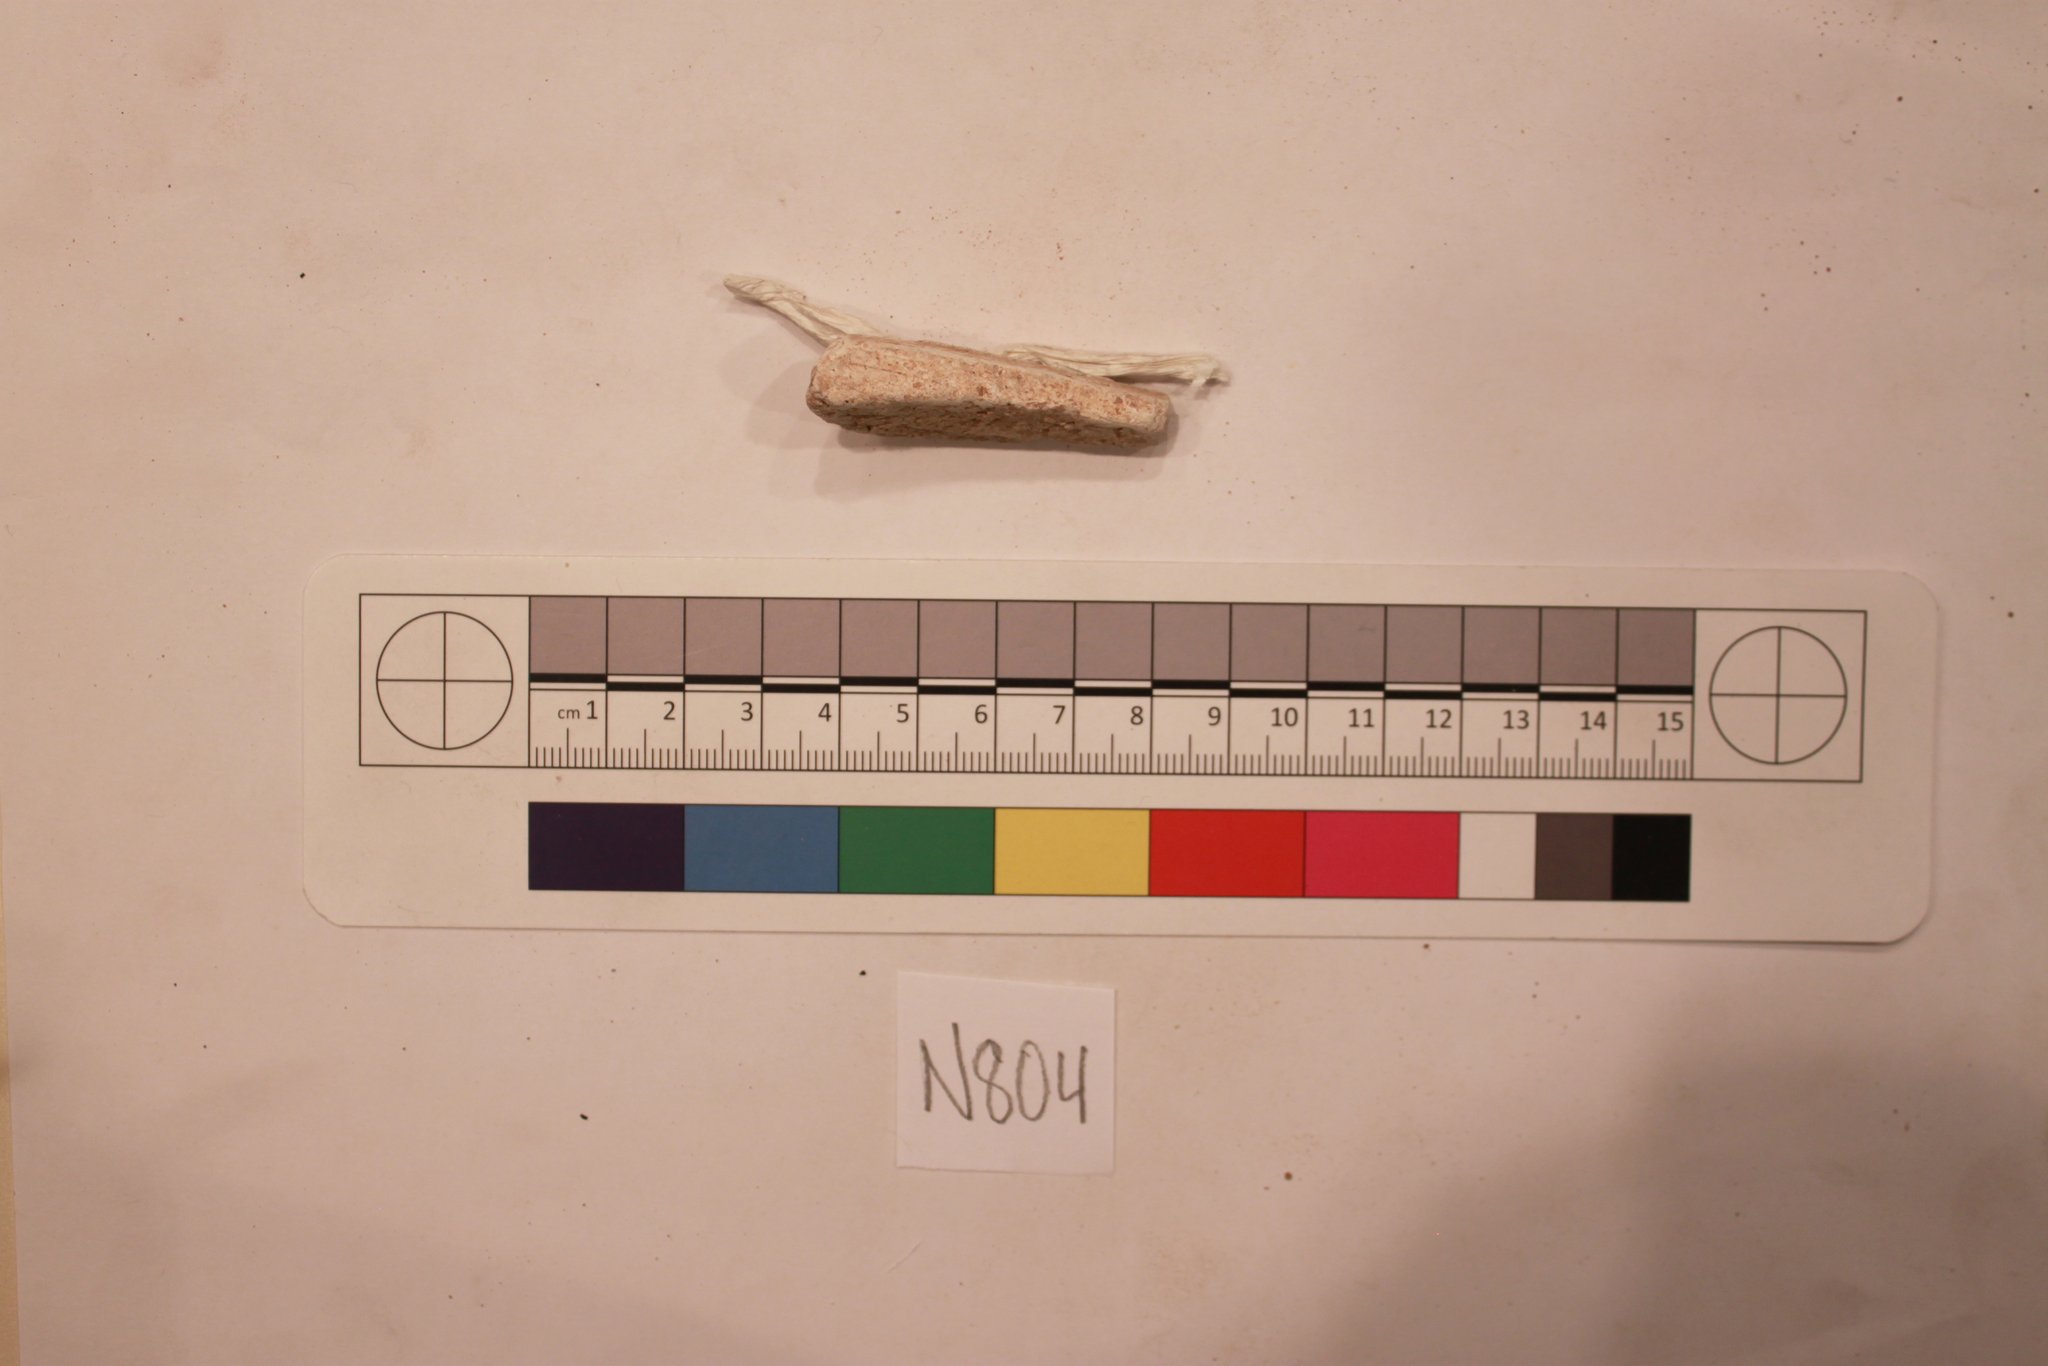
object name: fragment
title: Stucco Fragment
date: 701-1200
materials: plaster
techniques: carving, painting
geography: iran